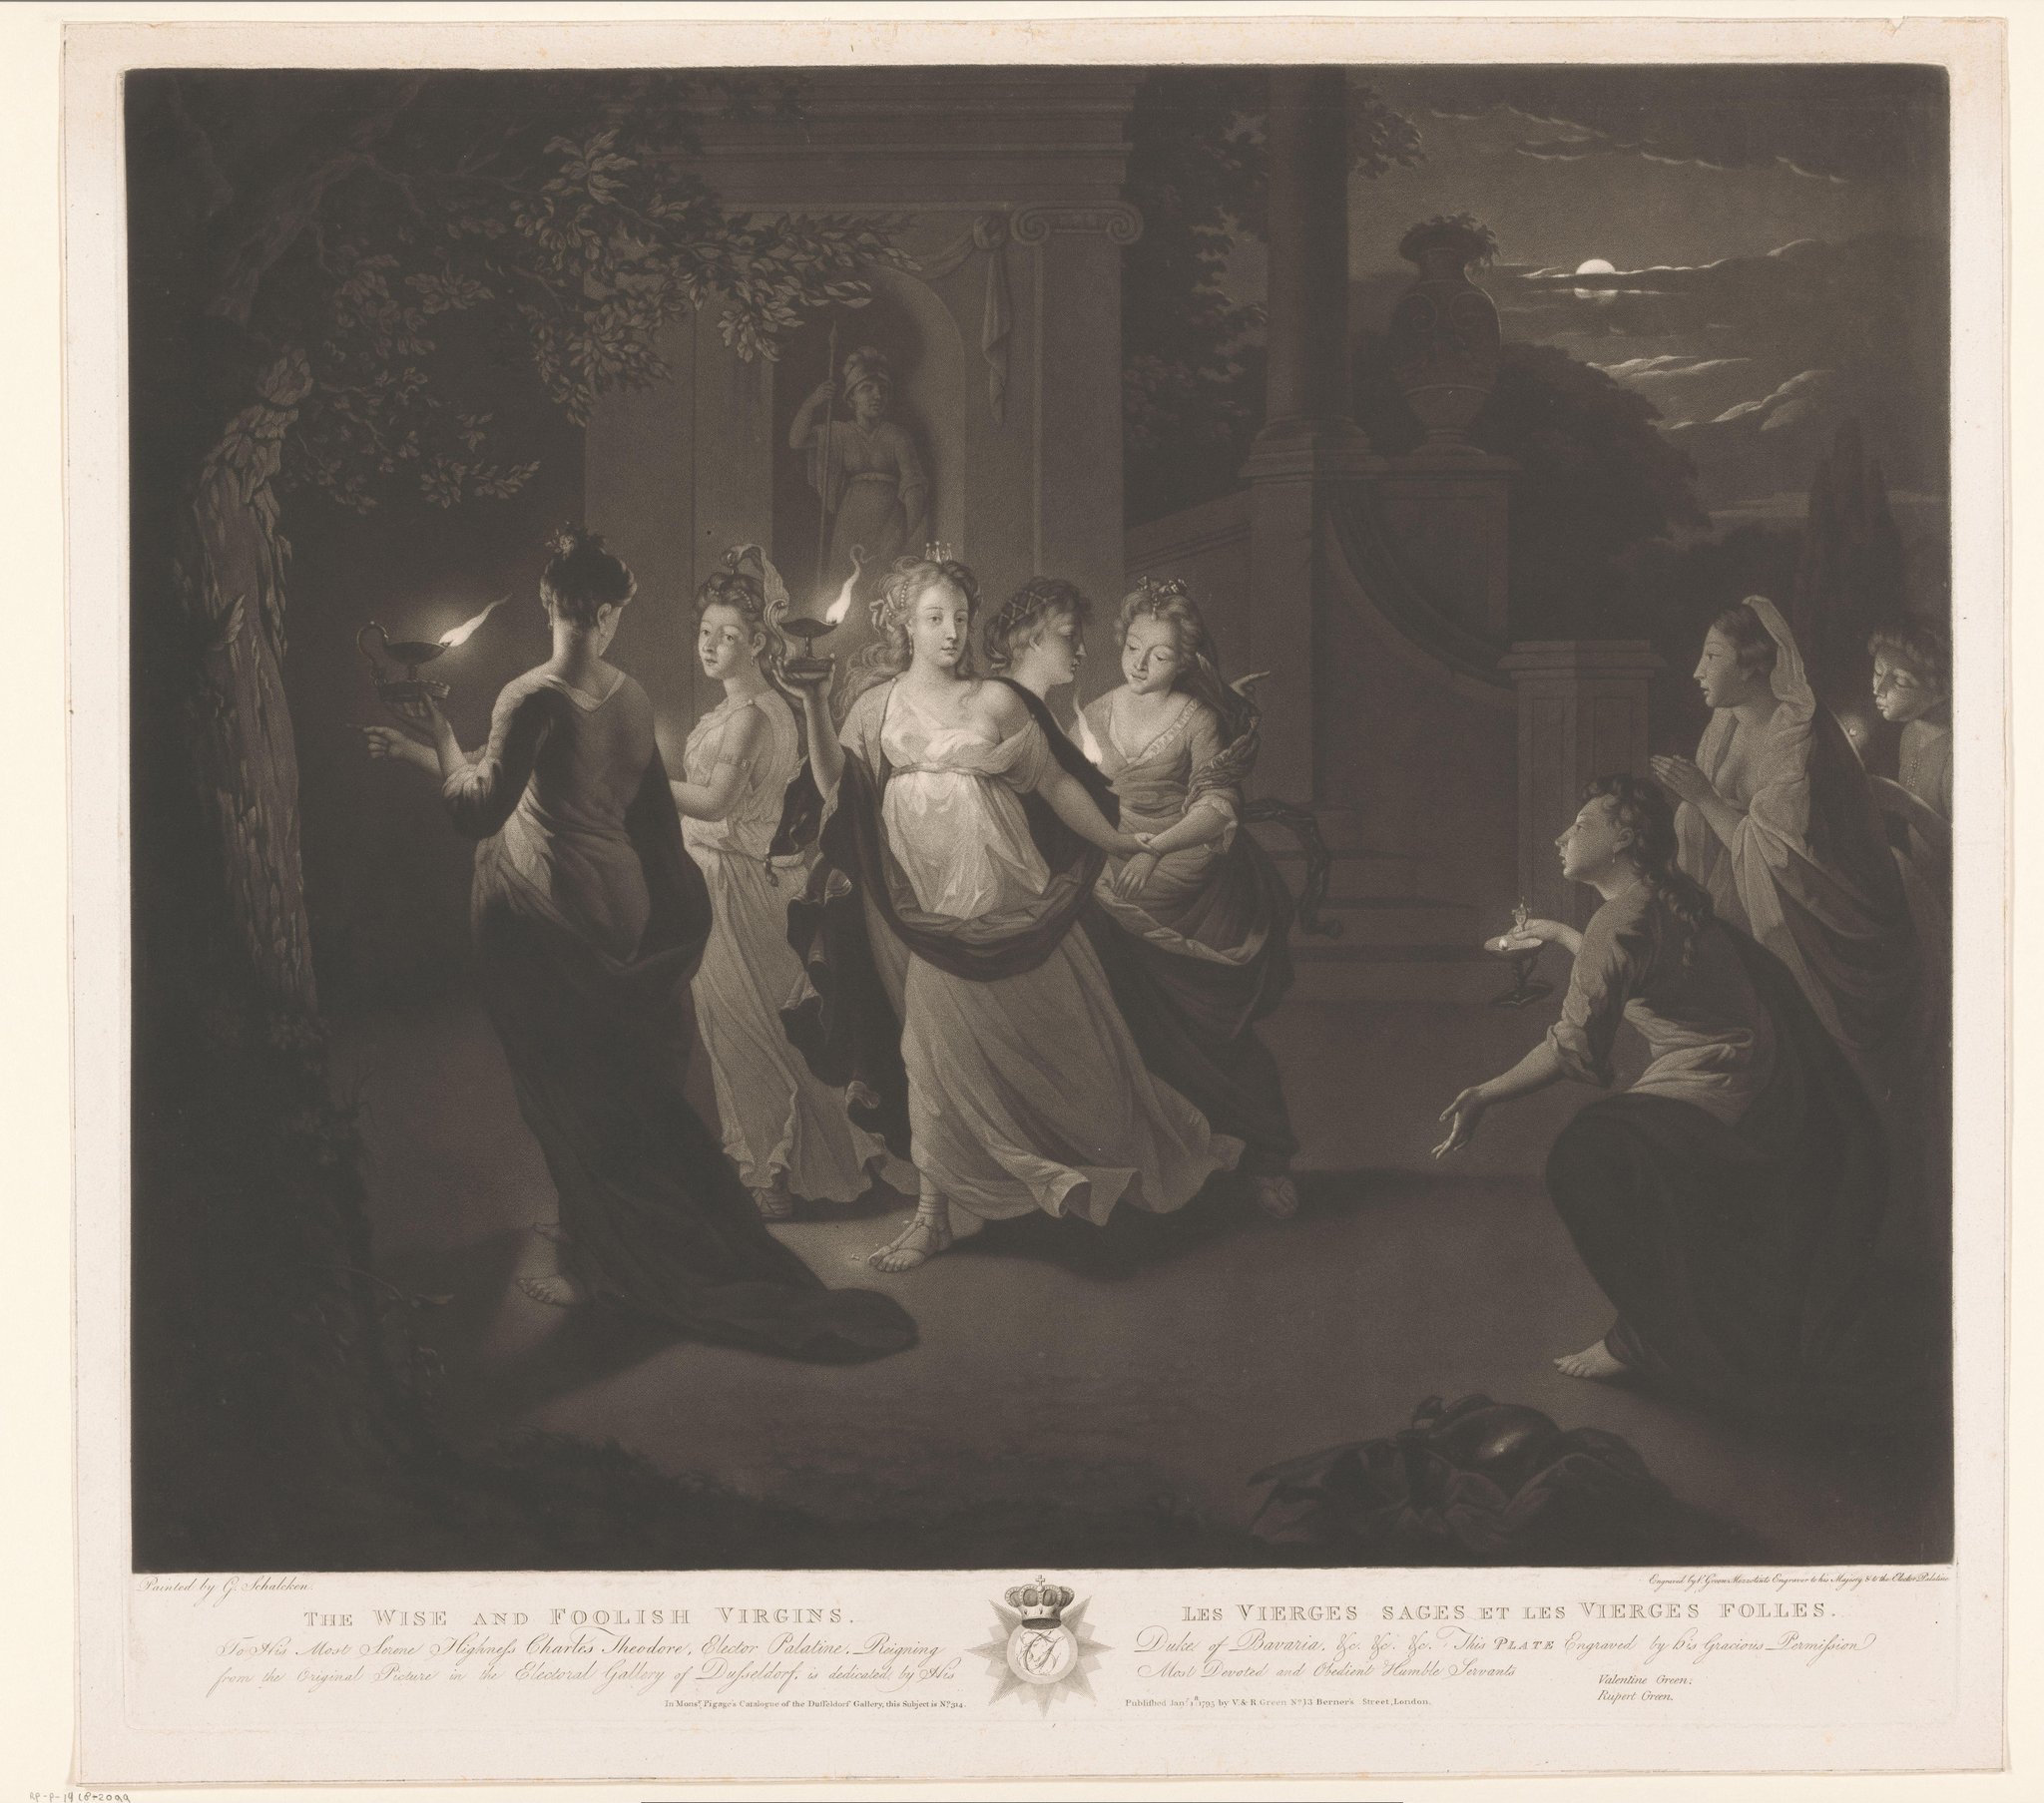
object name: print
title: Dwaze maagden vragen de wijze maagden om olie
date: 1701-1795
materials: paper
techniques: mezzotint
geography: london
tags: when the bridegroom arrives, all wake up and the foolish virgins ask the wise virgins oil for their lamps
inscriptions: collector's mark: Lugt 2228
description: Naast het adres van de uitgever staat: In Monsr. Pigage's Catalogue of the Dusseldorf Gallery, this Subject is No. 314.